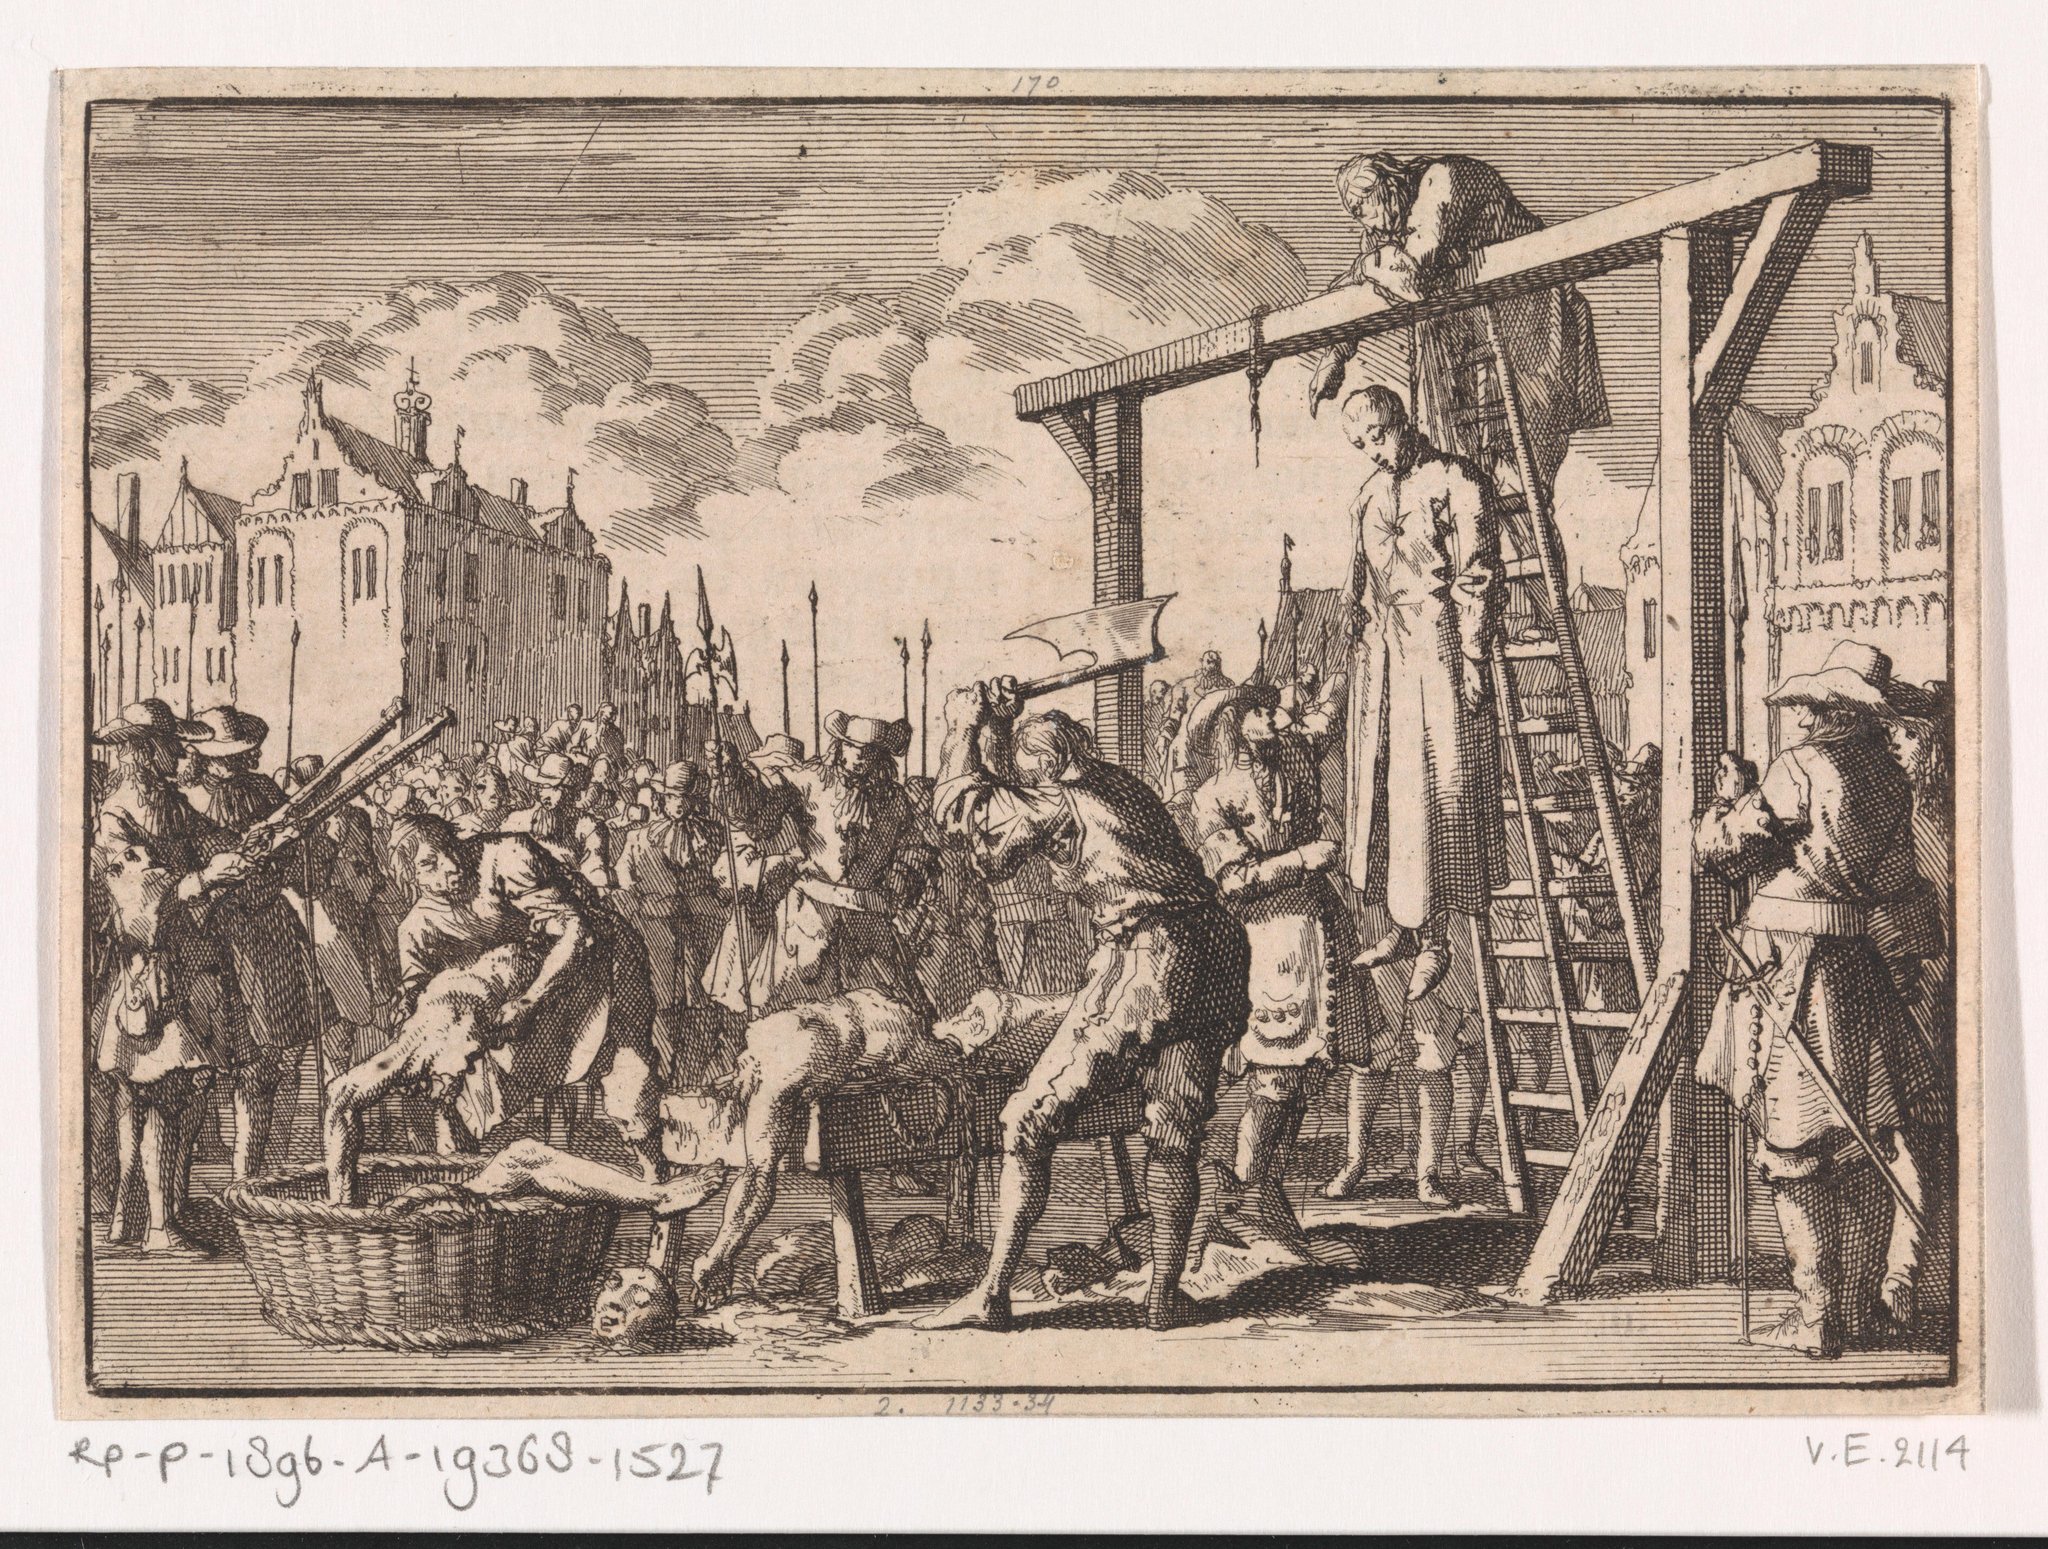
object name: book illustration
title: Te Londen wordt de Jezuïet William Ireland opgehangen en John Grove wordt gevierendeeld vanwege een voorgenomen koningsmoord, 1679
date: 1698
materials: paper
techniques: etching, letterpress printing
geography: leiden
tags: death penalty, execution, london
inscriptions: collector's mark: Lugt 2228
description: Illustratie uit: Gottfried, Johann Ludwig. Historische kronyck; vervattende een (...) beschrijvingh der aldergedenckwaerdigste geschiedenissen des weerelds, van den aenvangh der scheppingh tot (...) 1576 (2 delen). Leiden: Pieter van der Aa, 1698, dl. II, p. 1133.